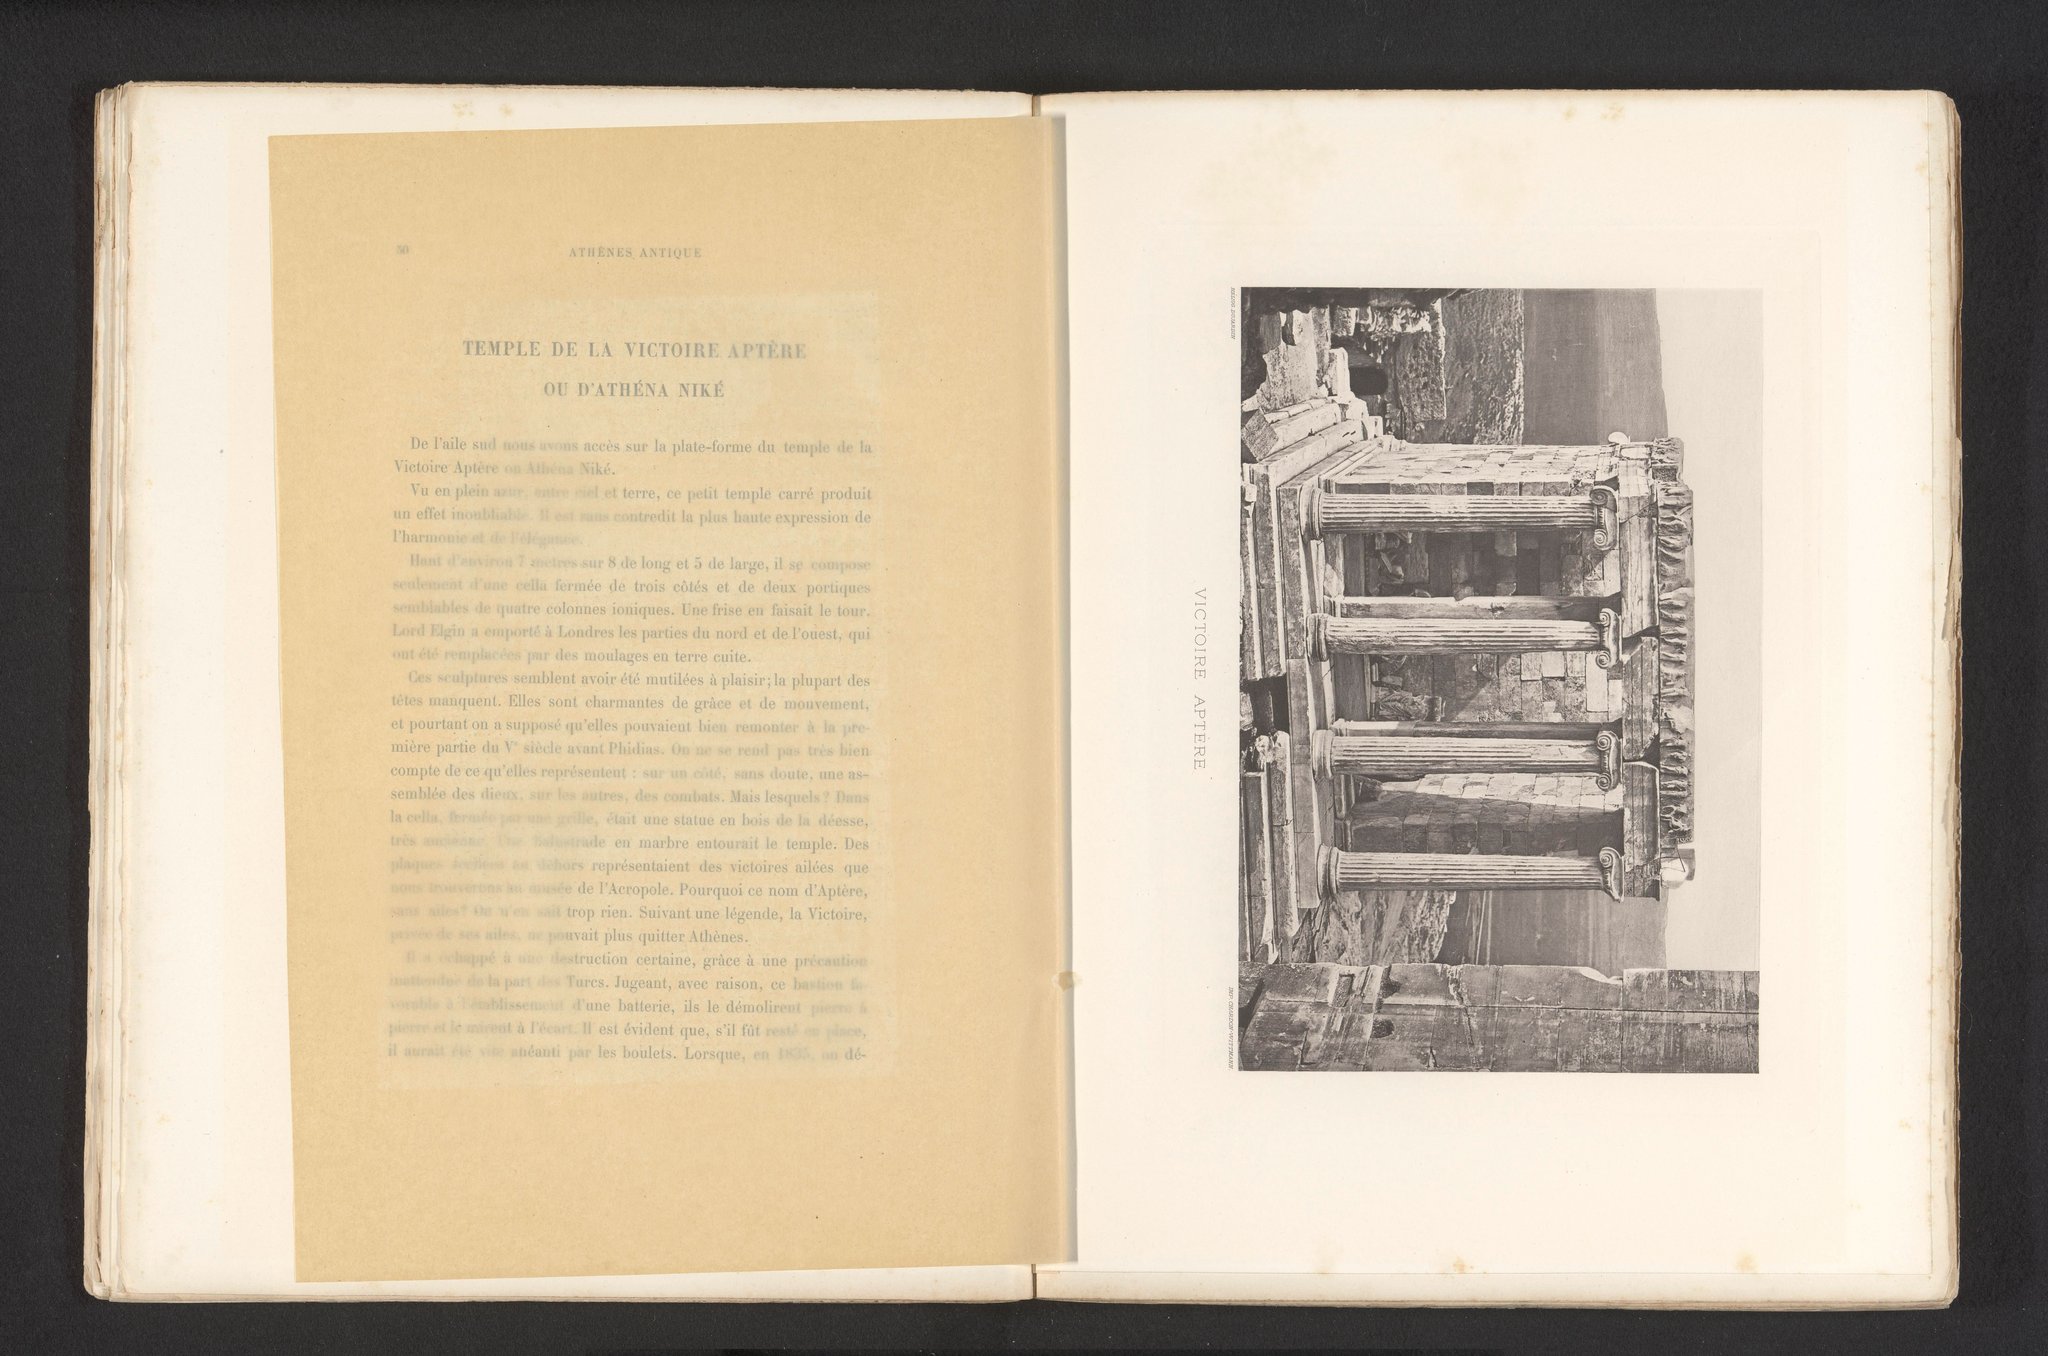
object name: page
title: Victoire aptère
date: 1880-1890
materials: paper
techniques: photoaquatint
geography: athens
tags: ruin of a building ~ architecture, temple, shrine ~ greek religion